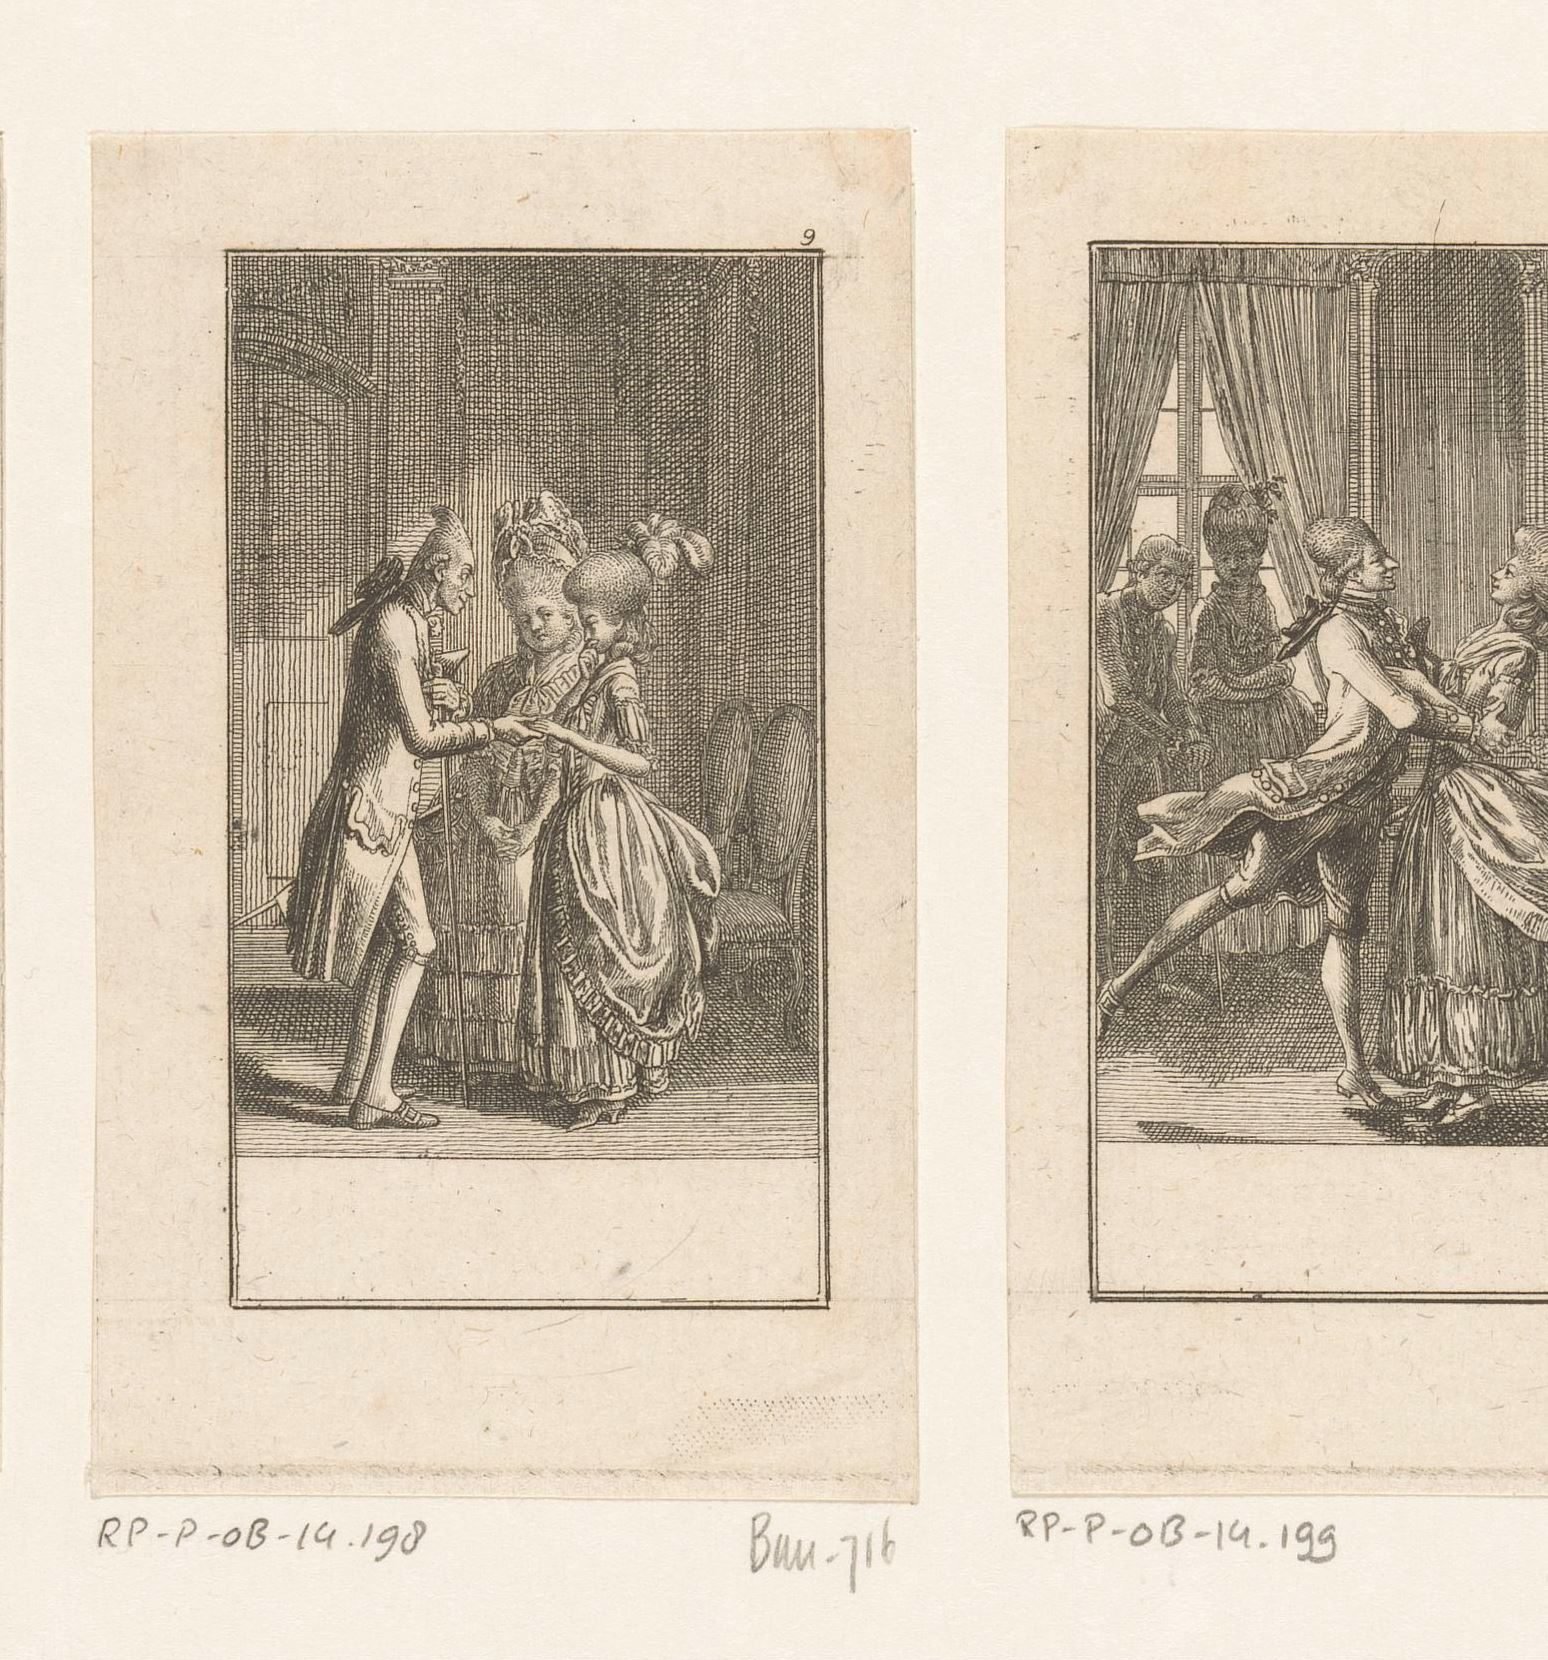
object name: print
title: Huwelijksaanzoek van een zieke man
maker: daniel nikolaus chodowiecki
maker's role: draughtsman, print maker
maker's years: 1726-1801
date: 1780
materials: paper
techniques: etching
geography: berlin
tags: proposal, declaration of love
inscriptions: collector's mark: Lugt 2228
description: Negende prent afkomstig uit een serie van twaalf huwelijksaanzoeken (eerste serie). De scènes zijn op een plaat geëtst. Een latere staat van deze serie is ook gebruikt in: Almanac de Goettingue pour l'année 1781. Mit Erklärung der 12 Blätter von Georg Christoph Lichtenberg. Göttingen: Johann Christian Dieterich.